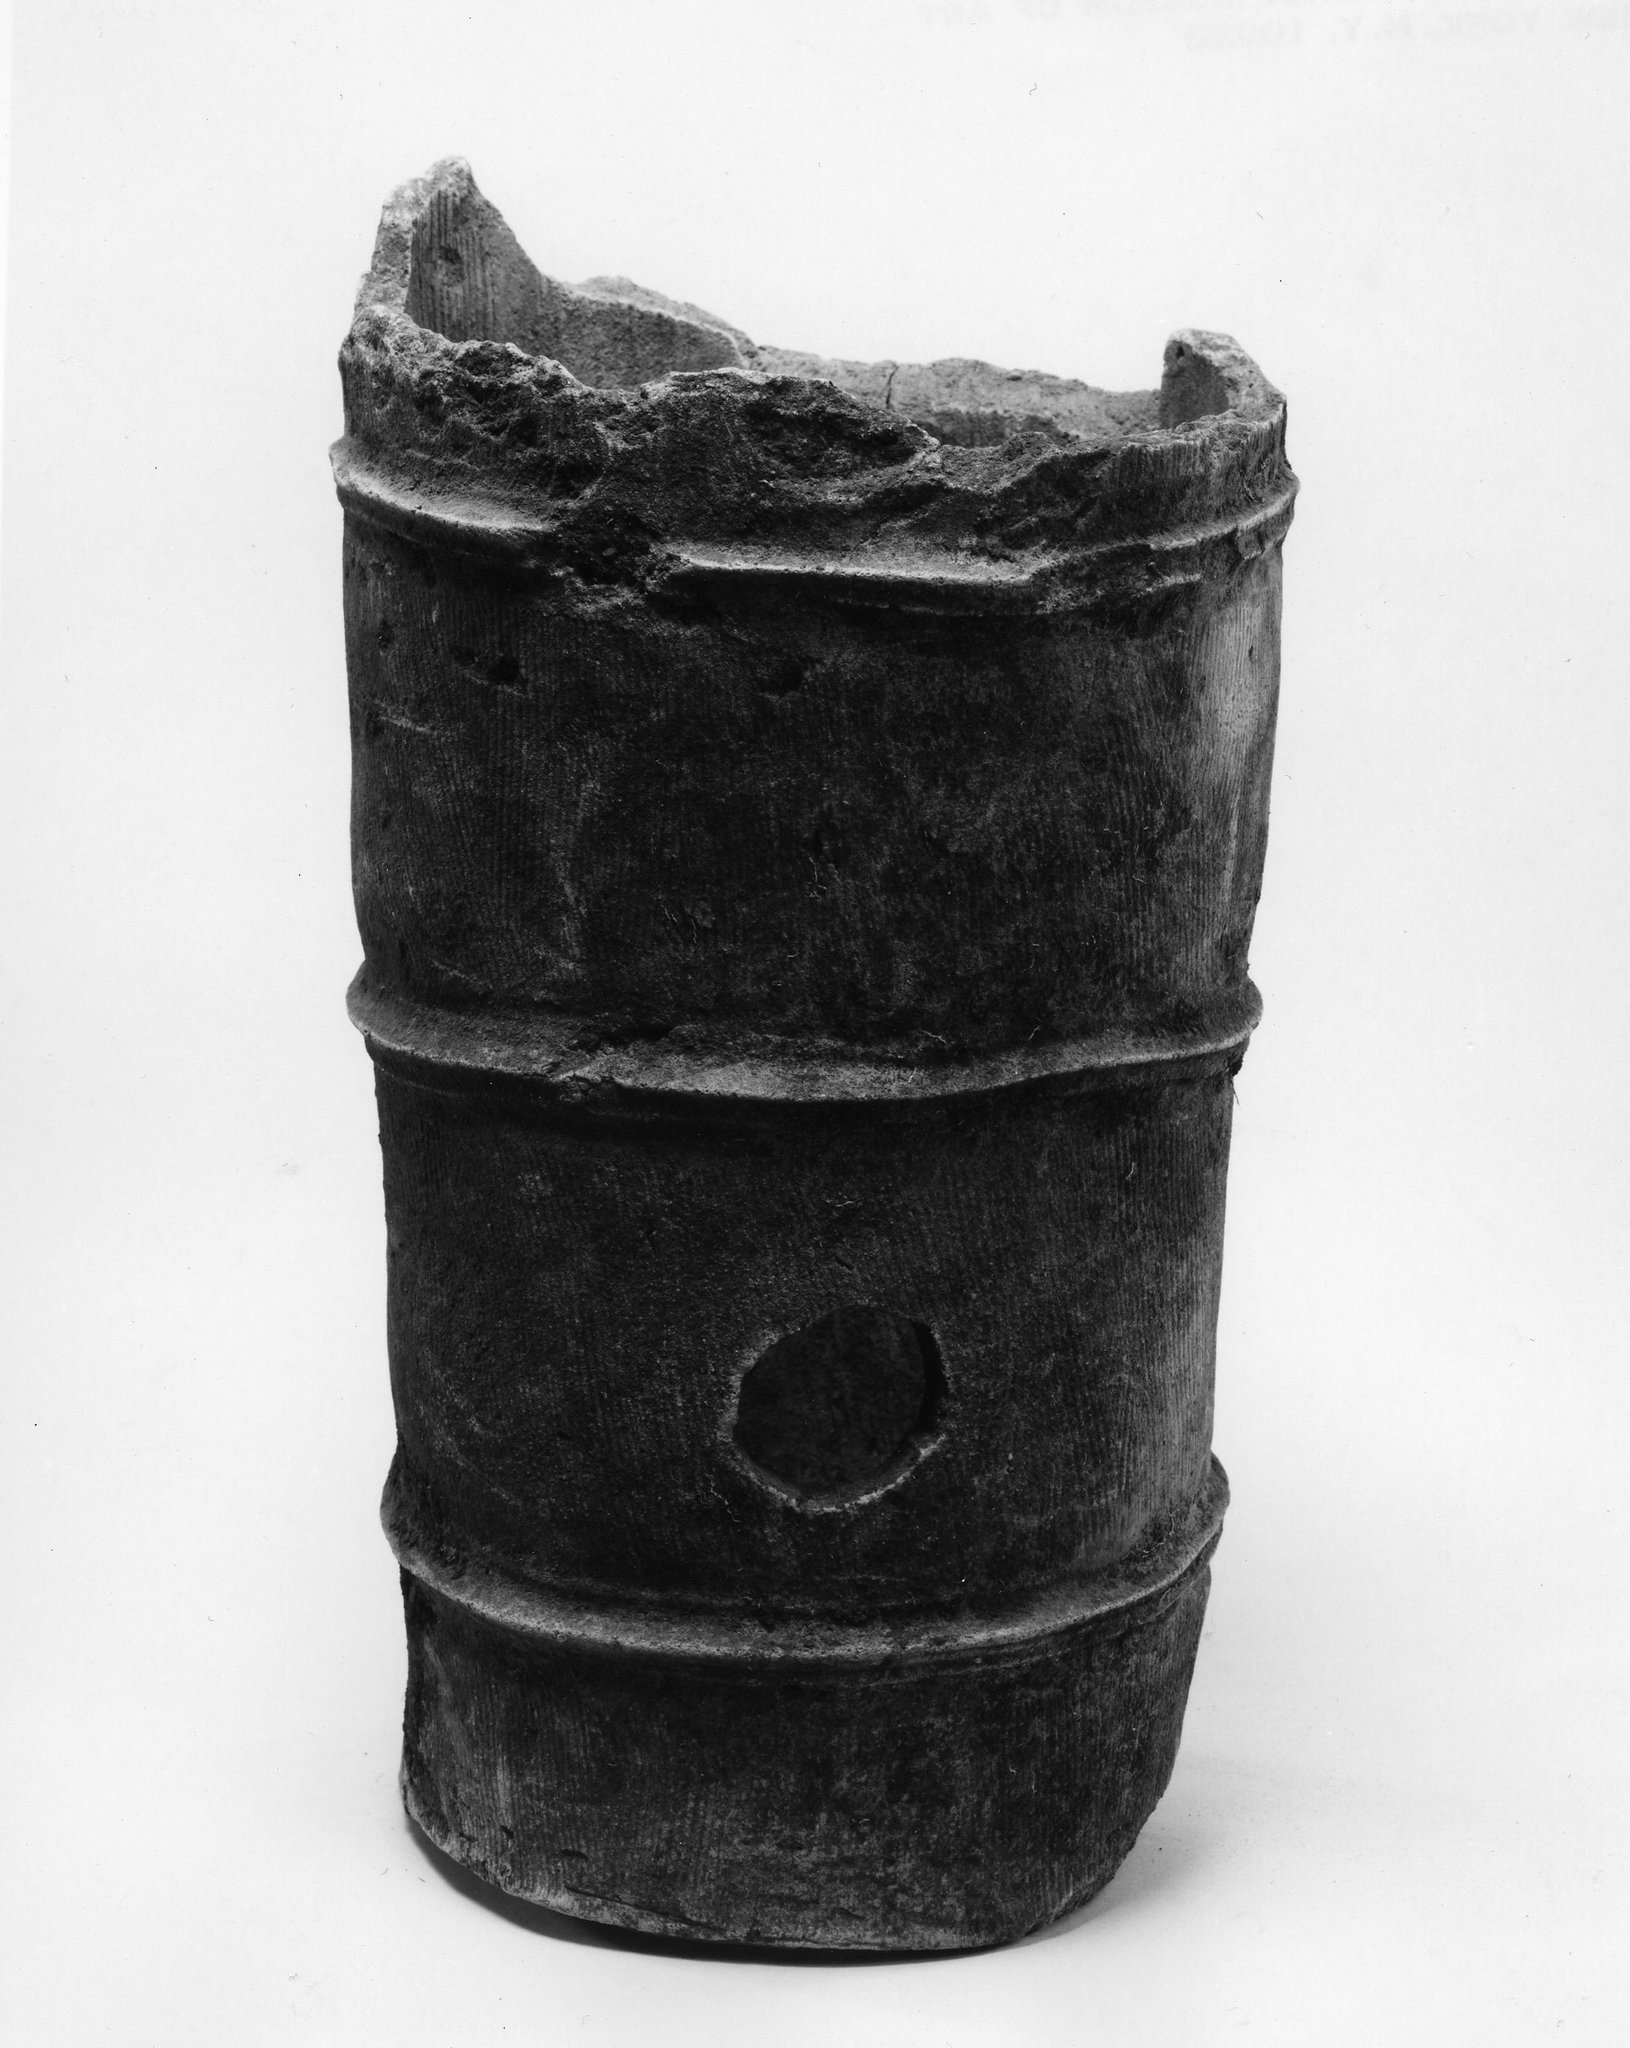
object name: haniwa fragment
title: Fragmentary haniwa cylinder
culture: japanese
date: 401-600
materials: clay